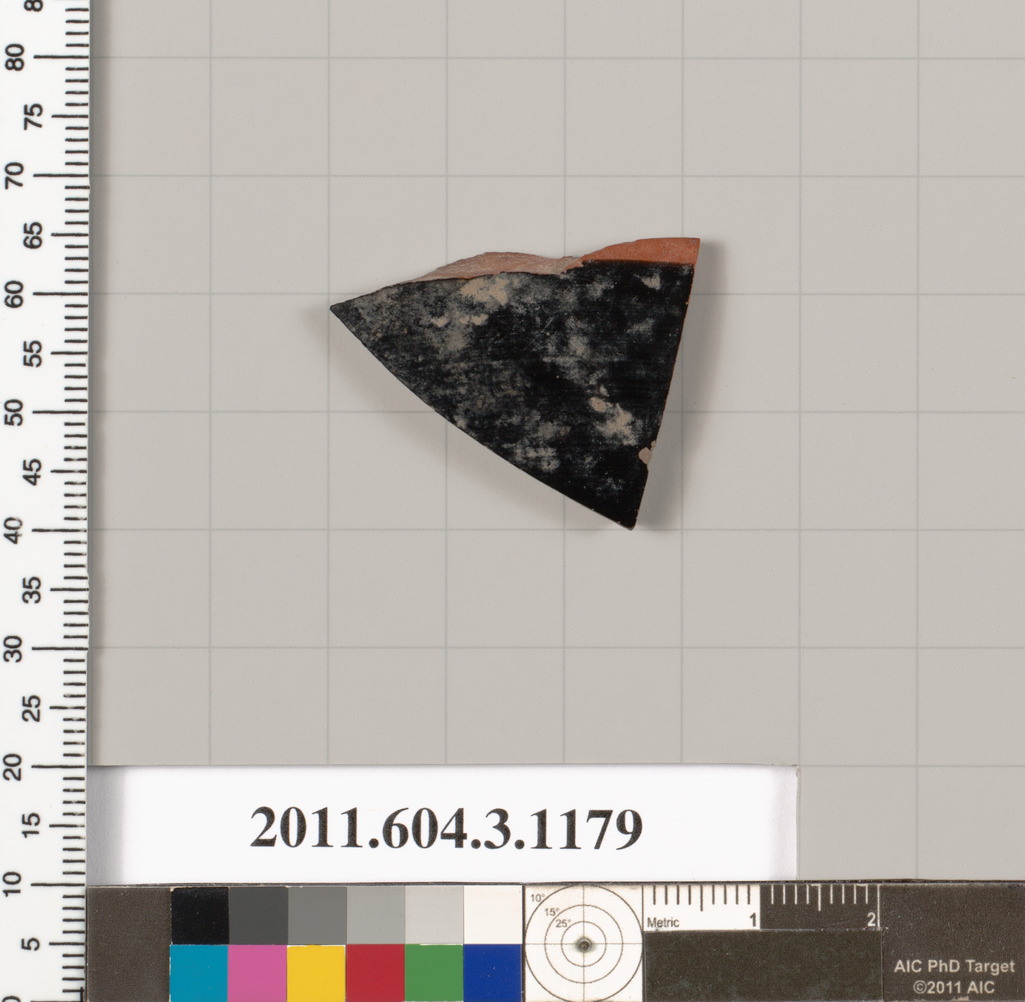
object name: mastoid or kyathos fragment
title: Terracotta fragment of a mastoid (drinking cup with narrow base) or a kyathos (cup-shaped ladle)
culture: greek, attic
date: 534-468 BCE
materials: terracotta